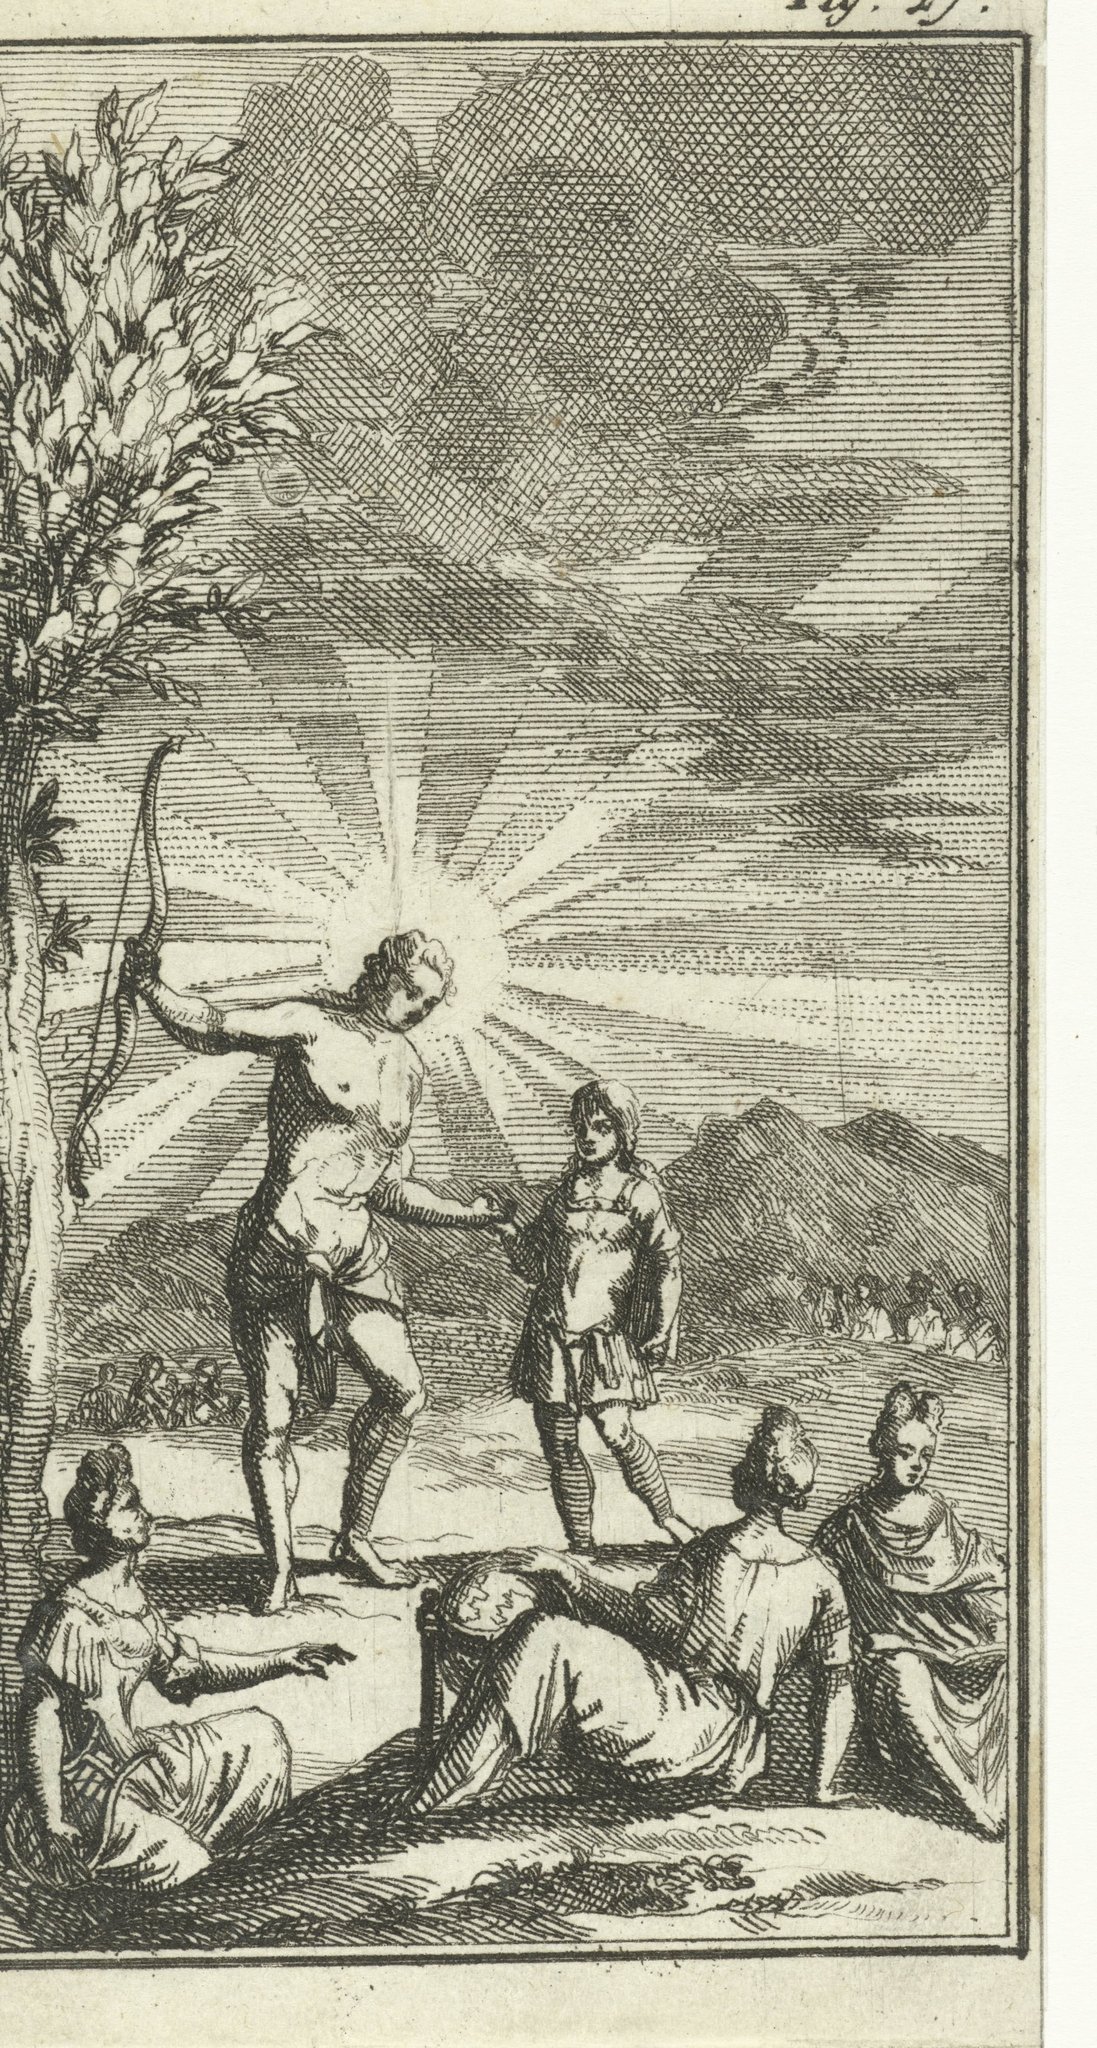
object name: print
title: Apollo toont een jongeling drie muzen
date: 1691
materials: paper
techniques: etching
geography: the hague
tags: (story of) apollo (phoebus), single muses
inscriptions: collector's mark: Lugt 2228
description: Illustratie uit: Beeck, Barent. Le triomphe royal, où l'on voit dêscrits les arcs de triomphe (...) erigez à la Haye, à l'honneur de Guillaume III. Den Haag, 1691.